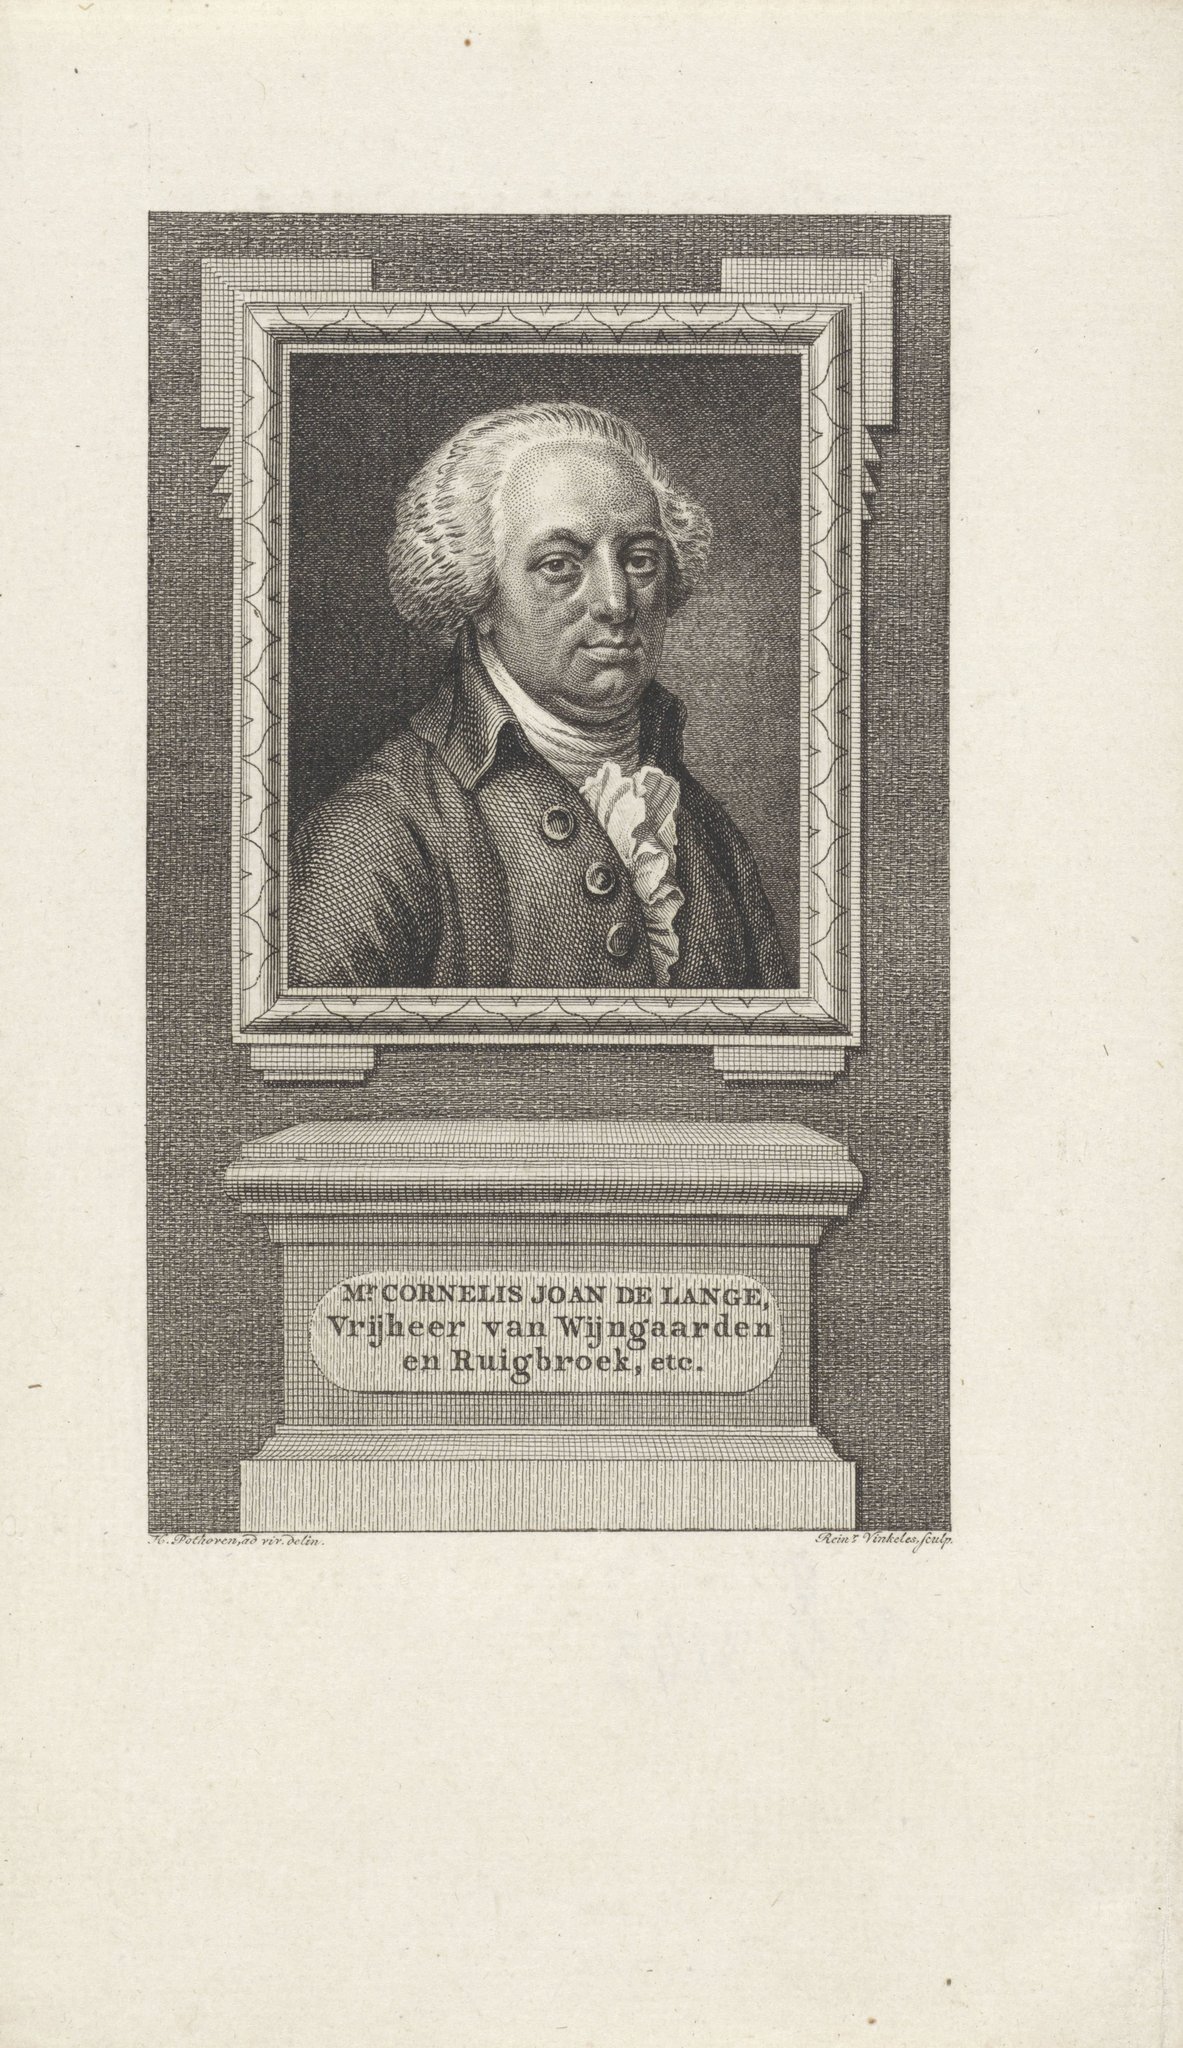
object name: print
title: Portret van Cornelis Johan de Lange van Wijngaarden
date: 1786-1809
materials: paper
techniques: engraving, etching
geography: amsterdam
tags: gouda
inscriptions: collector's mark: Lugt 2228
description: Prent ook gebruikt als boekillustratie in: Wagenaar, Jan. Vaderlandsche historie, (...) ten vervolge van Wagenaars Vaderlandsche historie. Dl. 1-43. Amsterdam: Johannes Allart, 1786-1809.